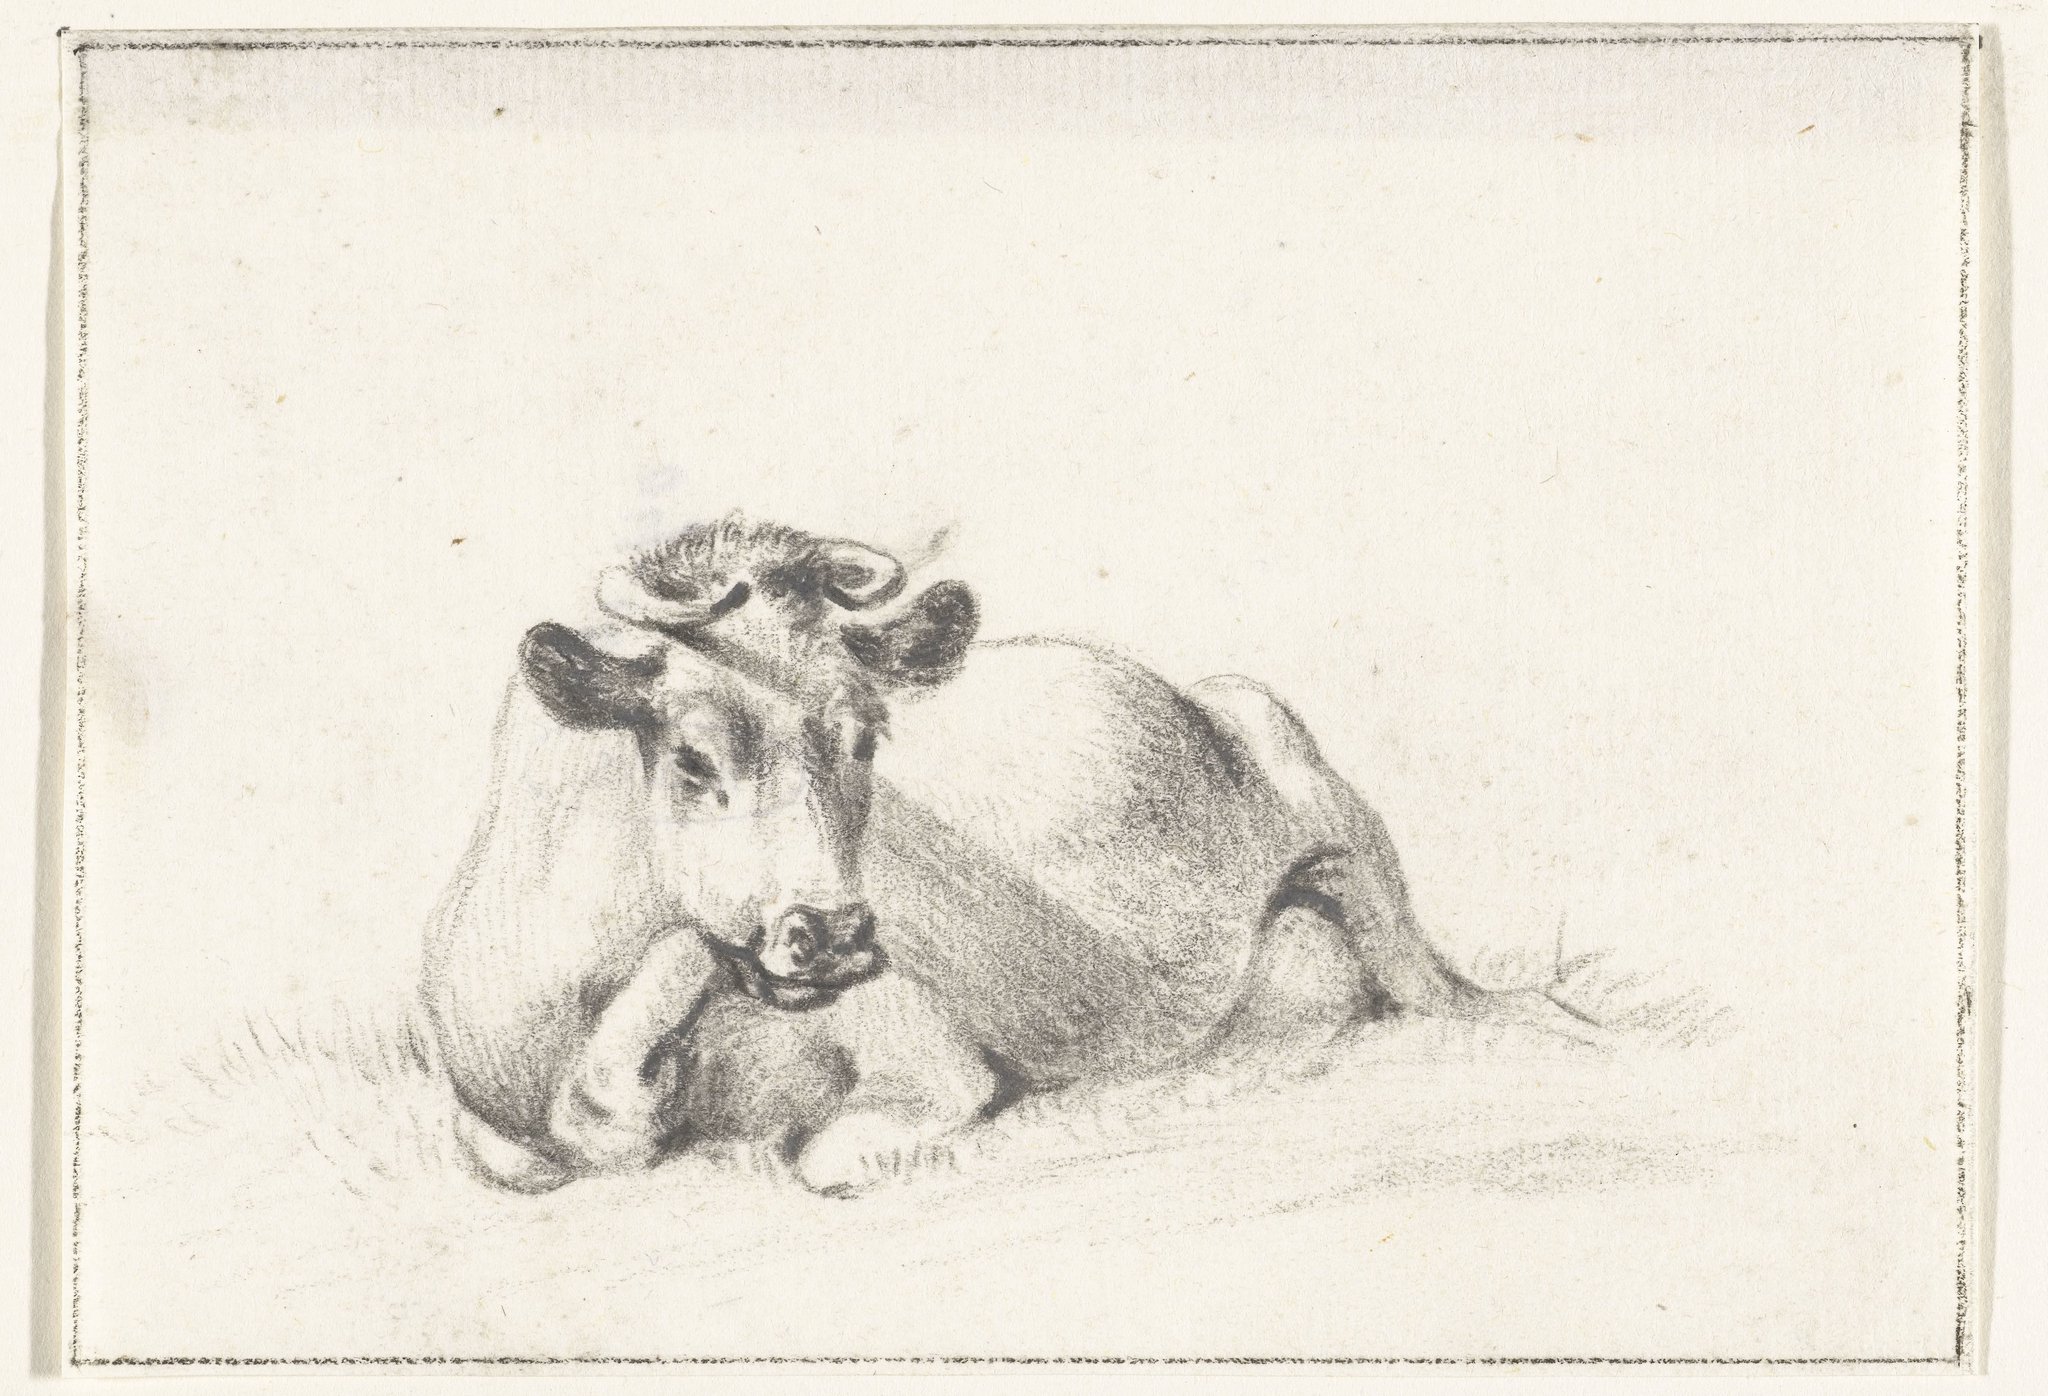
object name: drawing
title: Liggende koe, van voren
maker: jean bernard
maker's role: draughtsman, print maker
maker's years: 1765-1833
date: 1775-1833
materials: chalk, paper, pencil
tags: cow